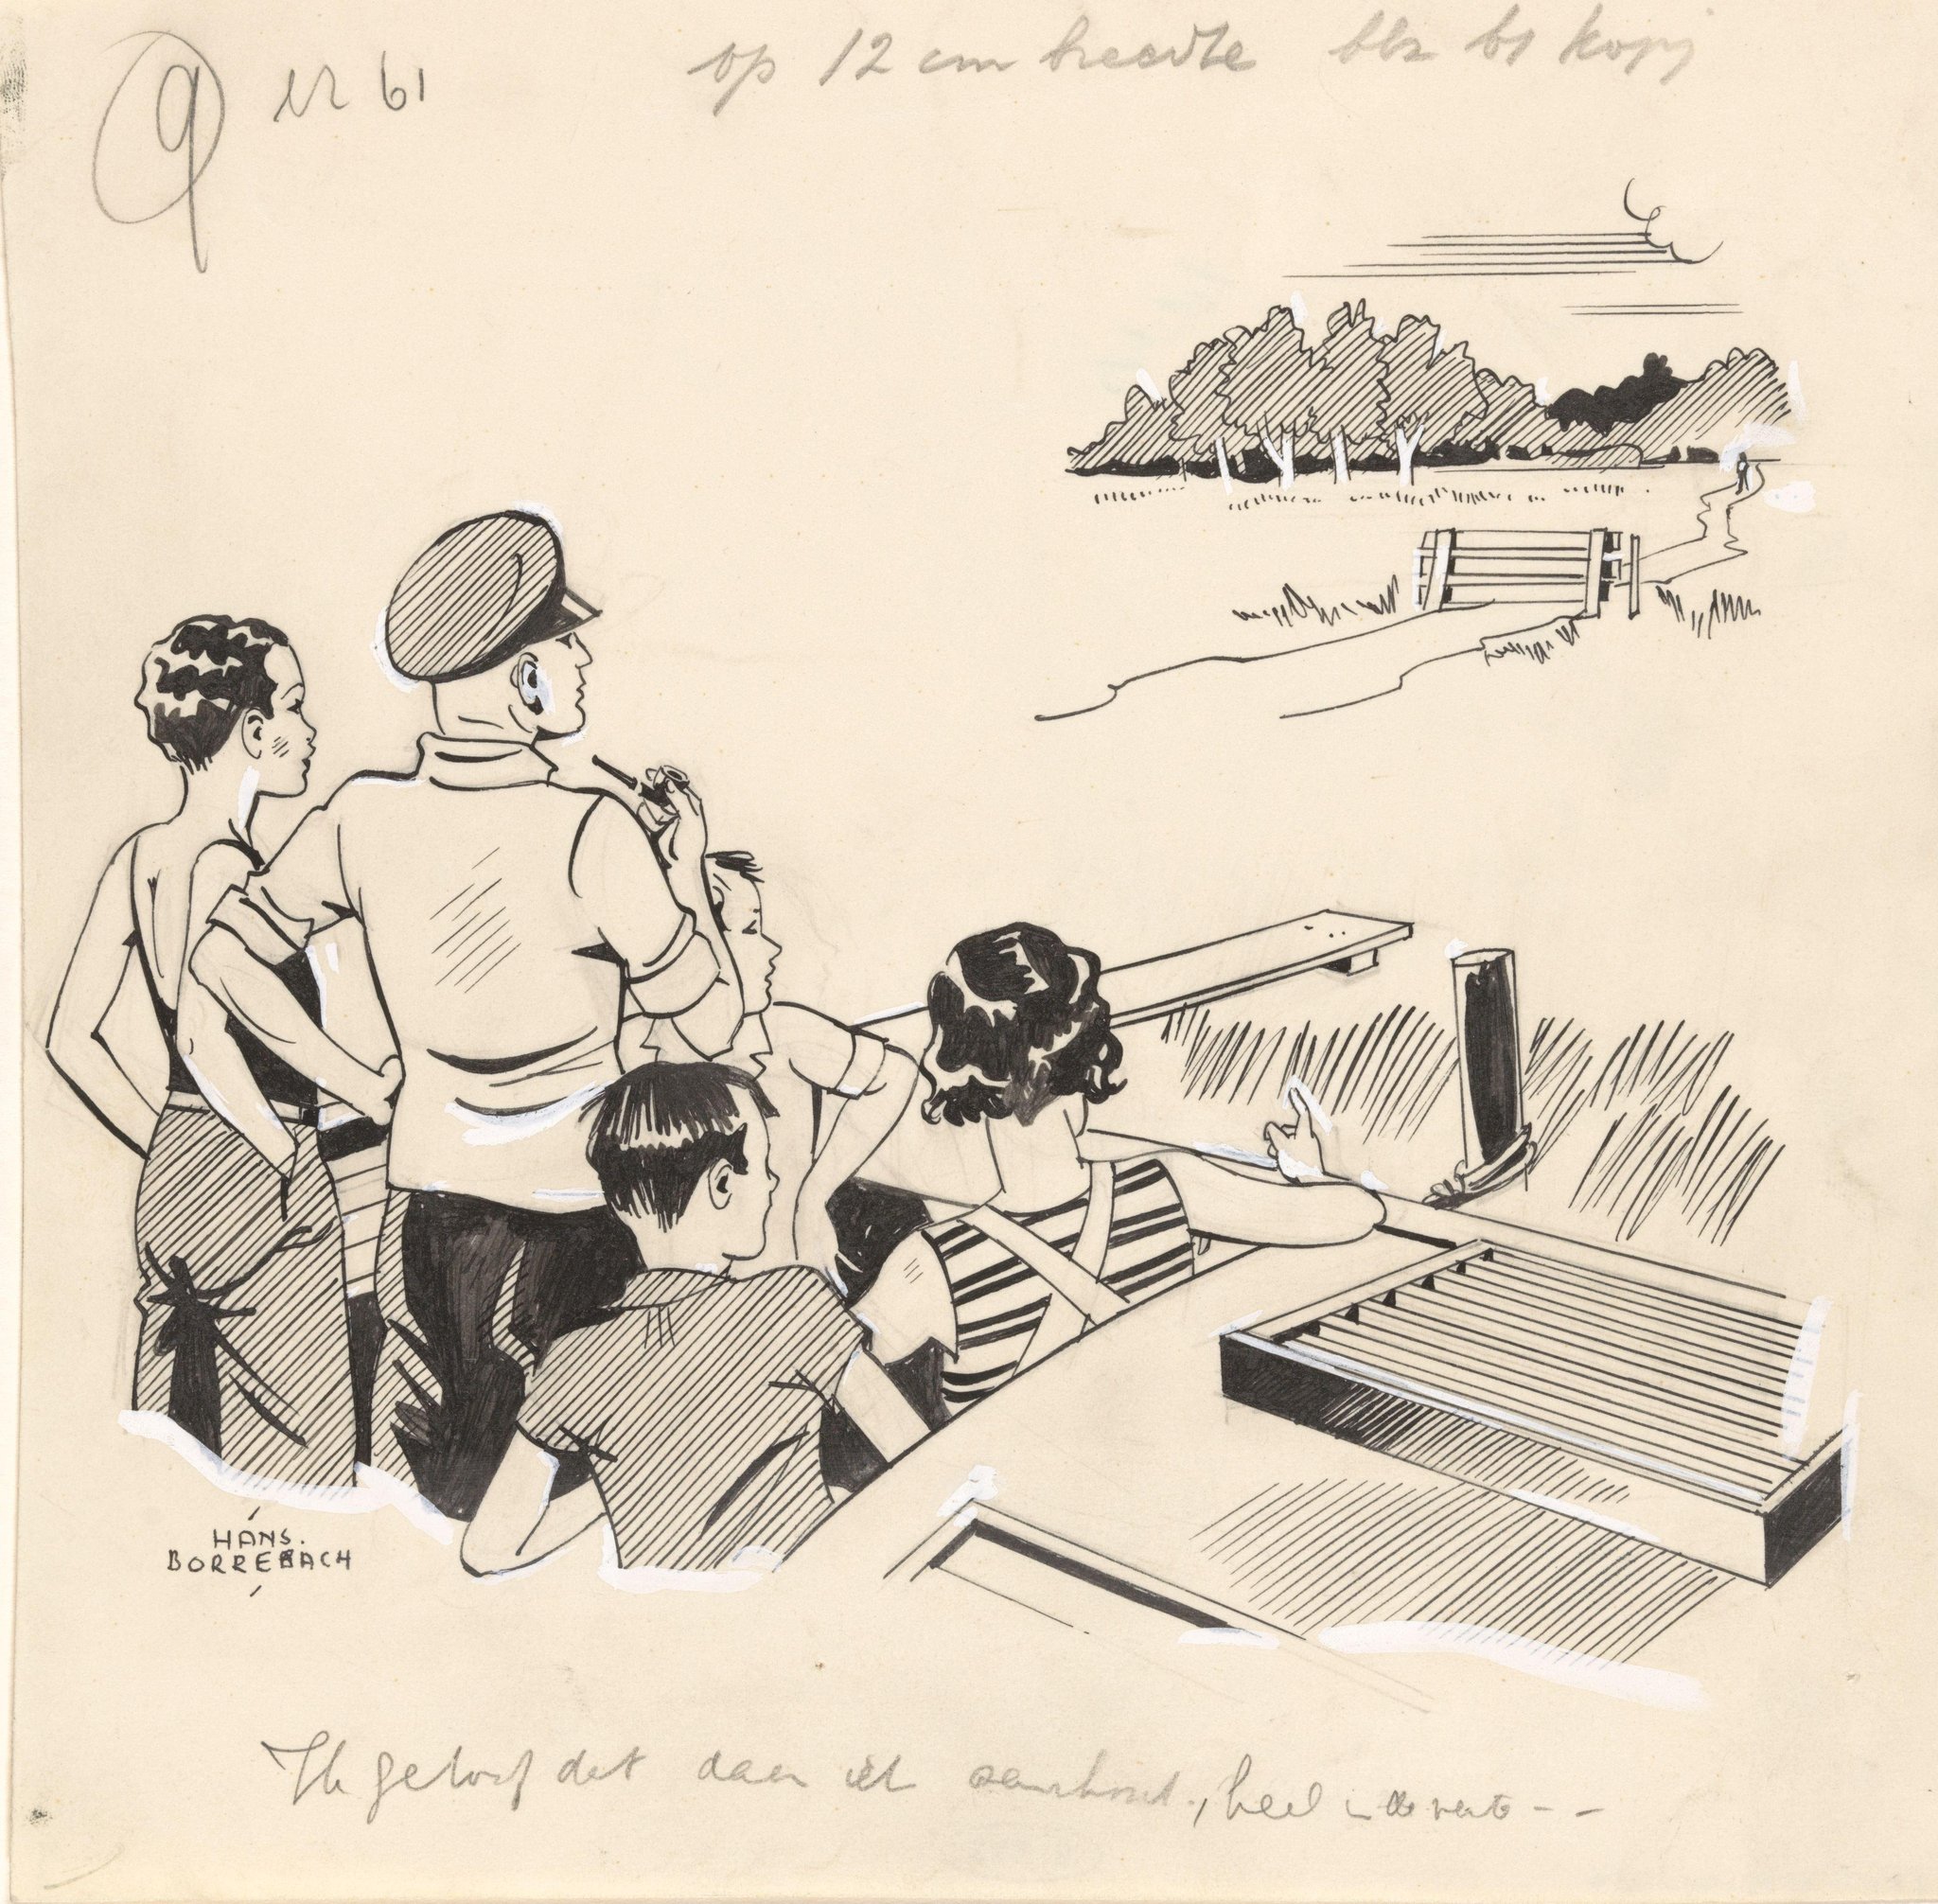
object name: boekillustratie ontwerp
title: Groep kijkt in de verte vanuit een boot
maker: hans borrebach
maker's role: draughtsman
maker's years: 1903-1991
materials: paint, ink, paper, pencil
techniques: brush, pen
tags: fence, wall, paling, pipe ~ tobacco, ships (in general)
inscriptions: collector's mark: Lugt 2228a, annotation: ‘9 bz 61/ Ik geloof dat daar iets aankomt, heel in de verte ..’, :, signature: ‘HANS./ BORREBACH’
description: In een aangemeerde boot staan en zitten vijf mensen, onder wie twee jongens en een man met een pijp. Ze kijken in de verte naar een pad in een landschap met bomen. Over het pad komt een figuur aanlopen.